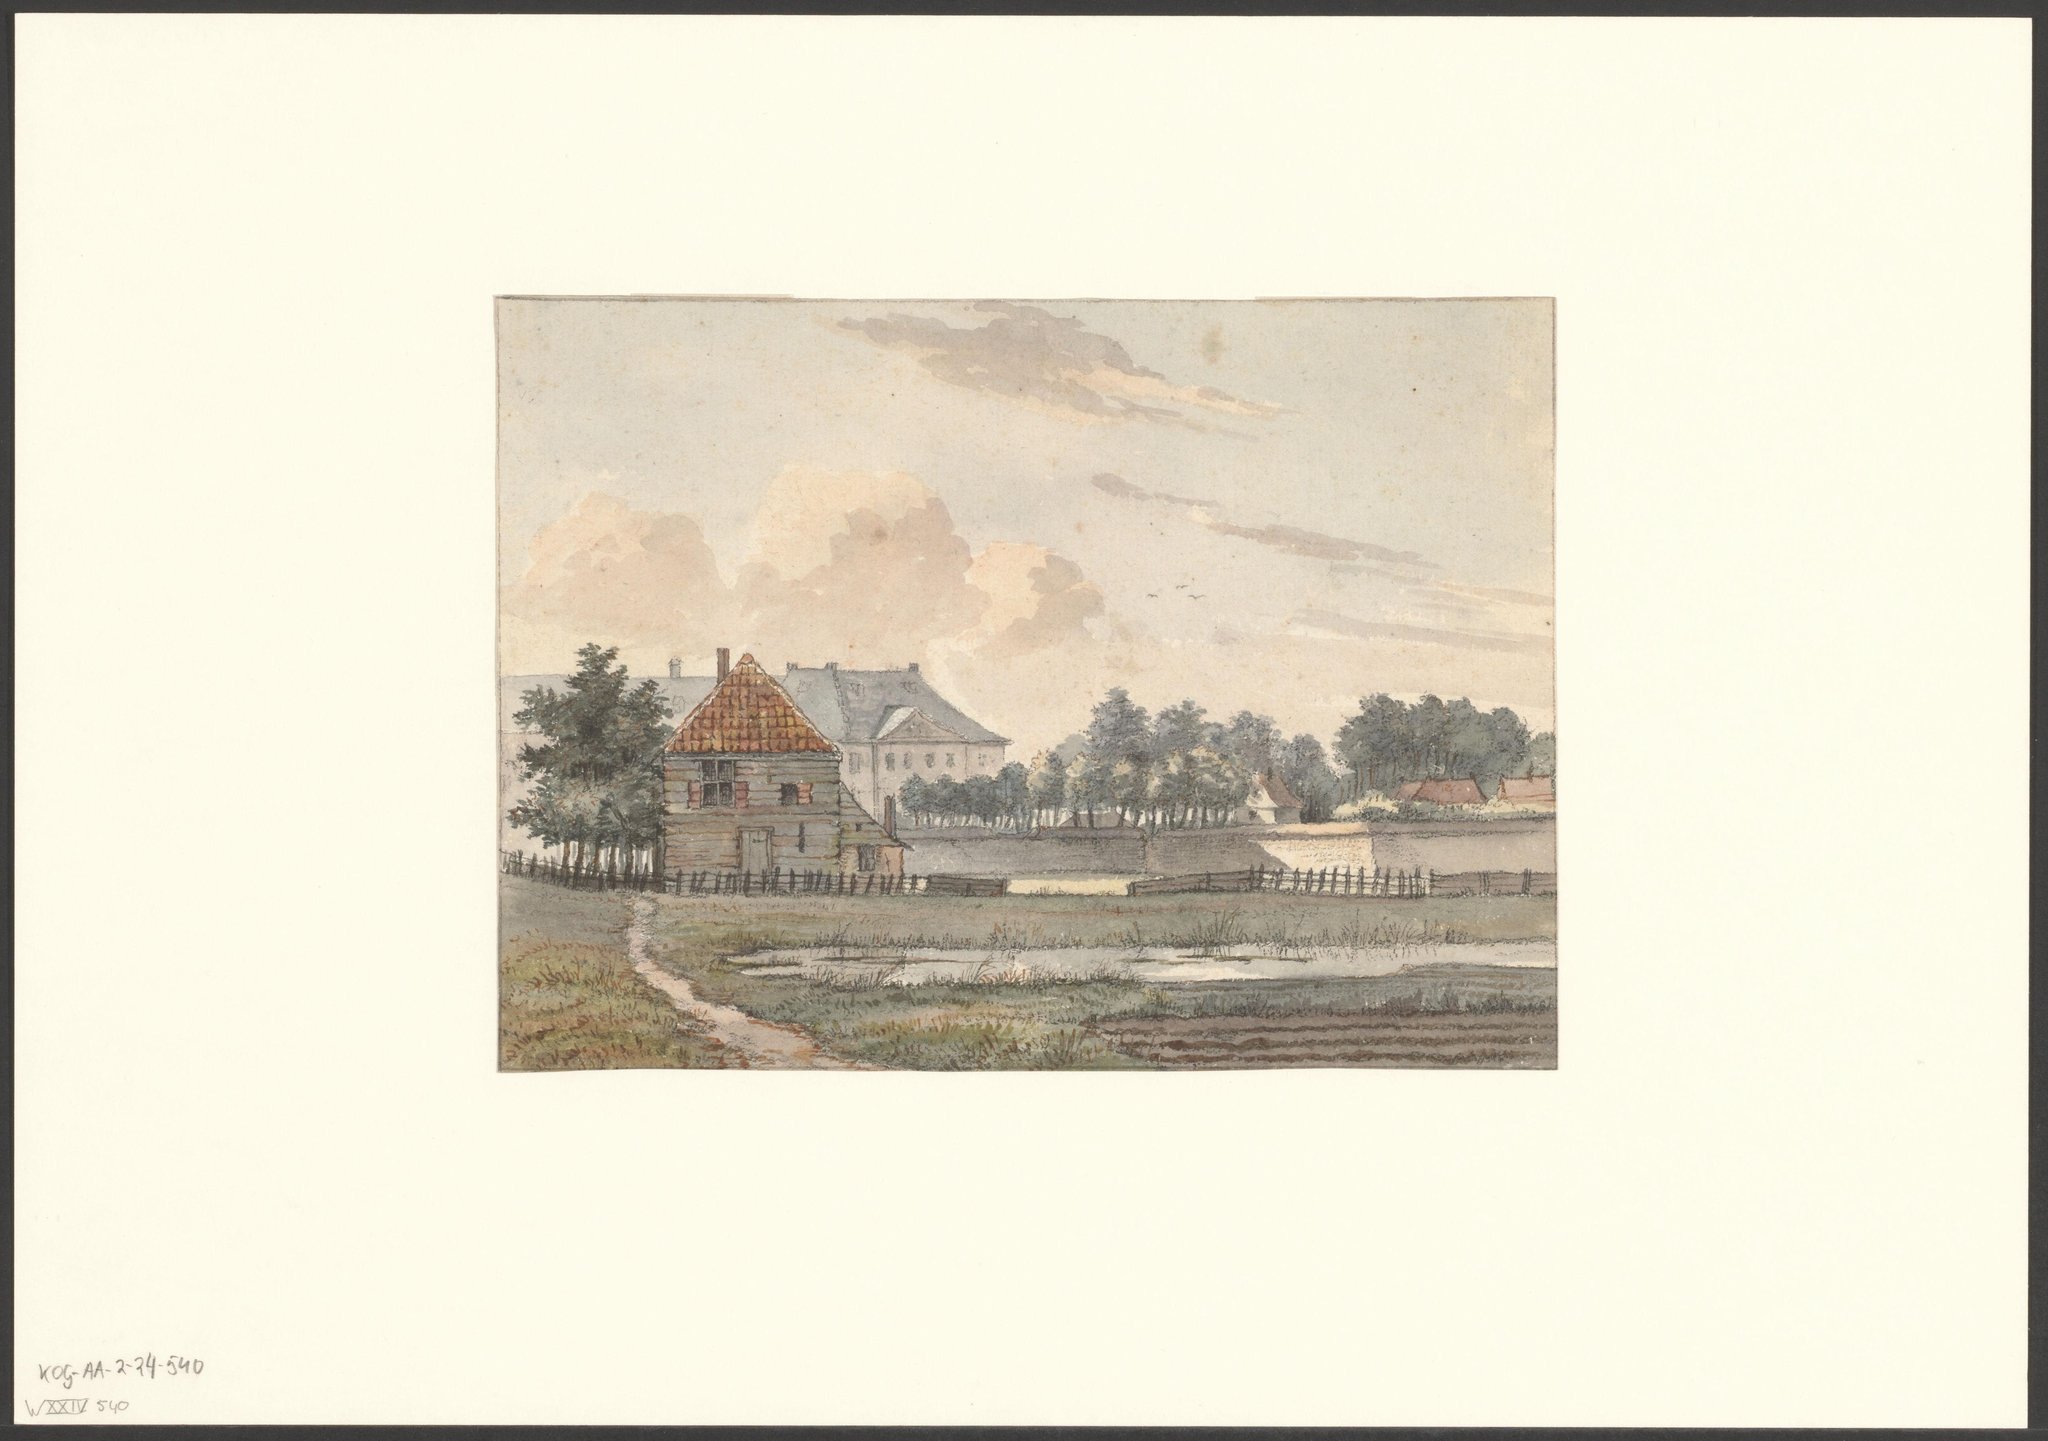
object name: drawing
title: Gezicht op de Singelgracht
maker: hendrik gerrit ten cate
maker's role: draughtsman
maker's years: 1803-1856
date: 1824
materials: gouache, paper, pencil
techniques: brush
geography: amsterdam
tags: city-view in general; 'veduta', canal, farm or solitary house in landscape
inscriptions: collector's mark: Lugt 800a, signature: ‘H:G: ten Cate jr / fec 1824’, collector's mark: Lugt 1713a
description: Tekening binnen de Atlas Van Eck ingedeeld op wijknummer 25.